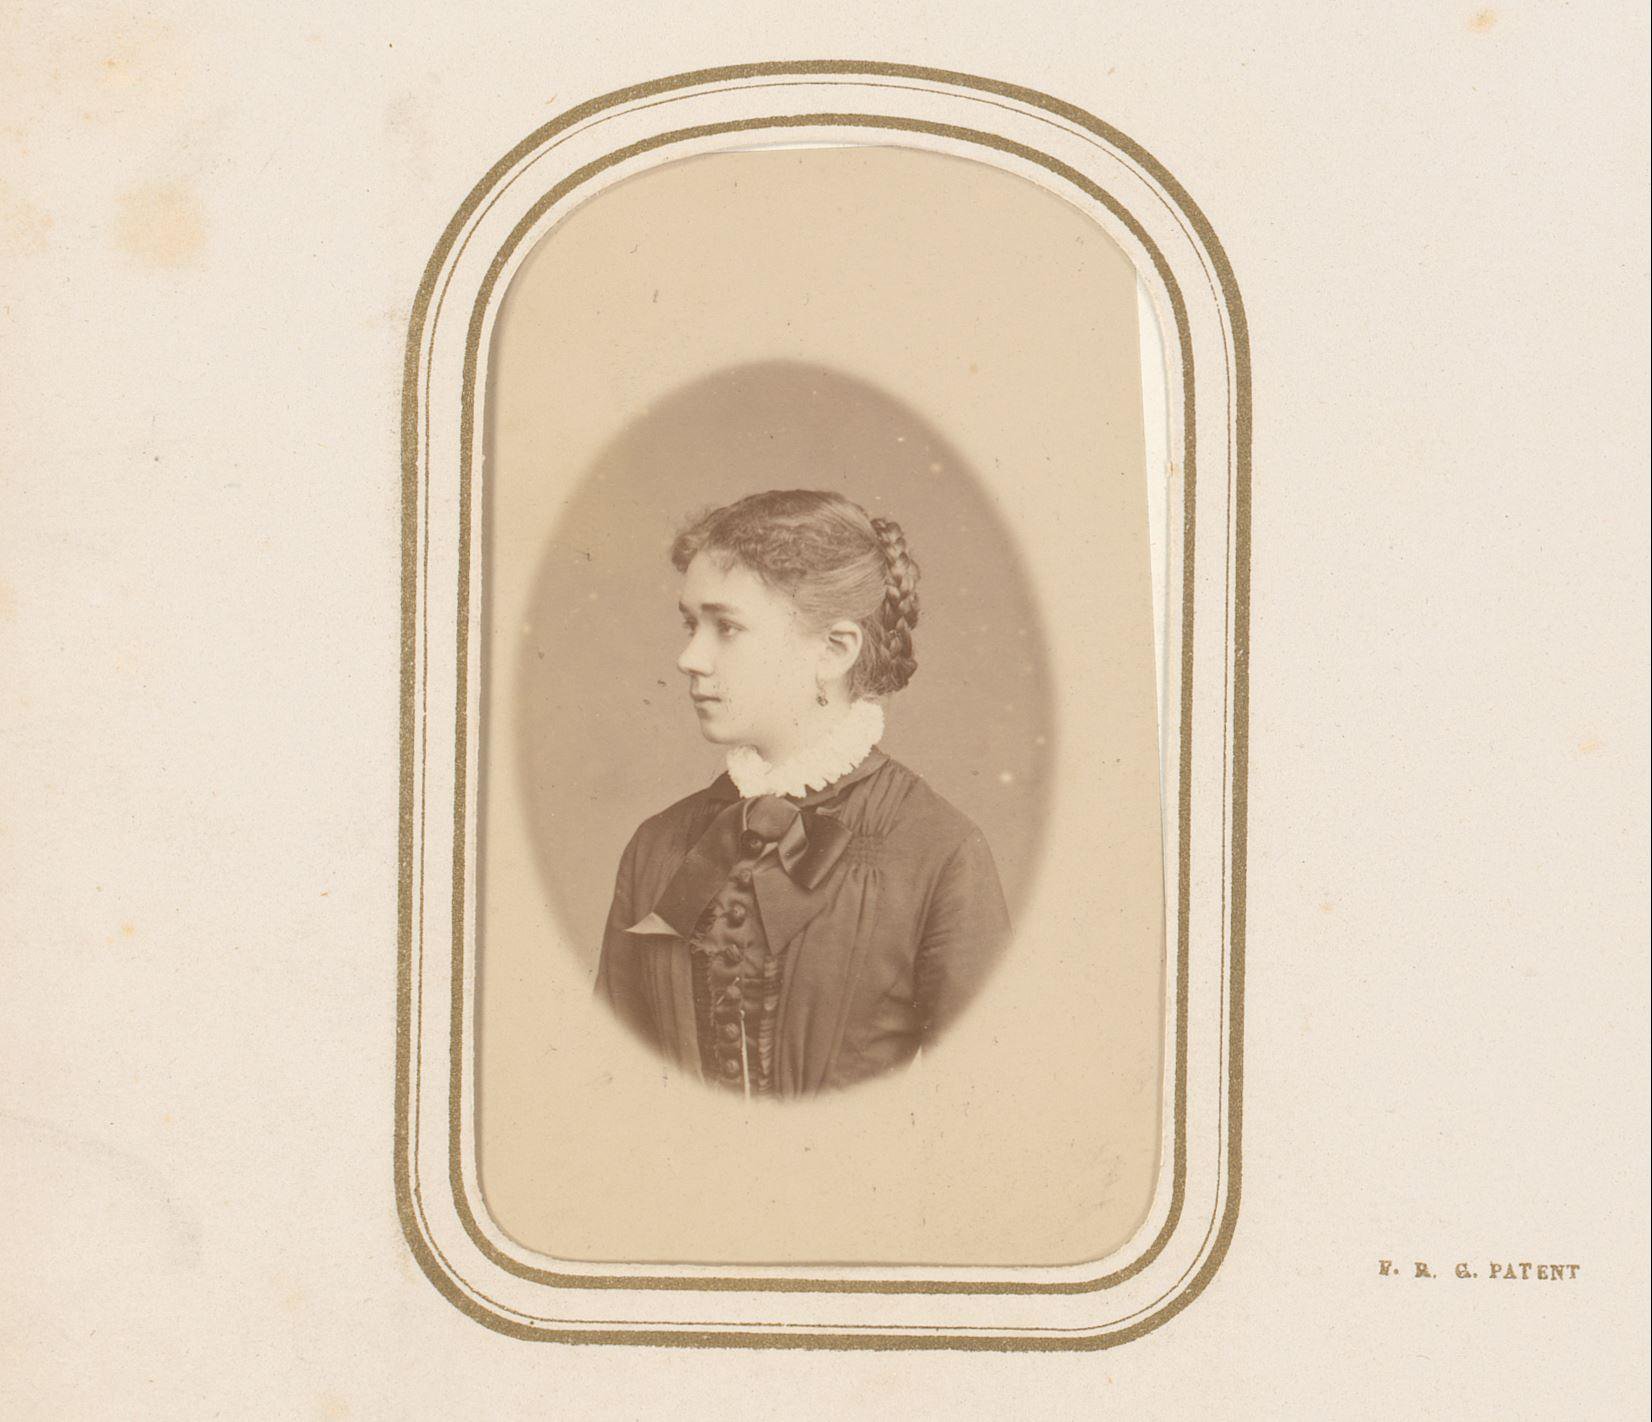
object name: photograph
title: Portret van een jonge vrouw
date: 1874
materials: cardboard, photographic support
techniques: albumen print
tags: adolescent, young woman, maiden, historical persons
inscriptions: number: ‘24048’, inscription: ‘Chambay/ Grand Hotel/ Bould des Capucines 12/ Paris’